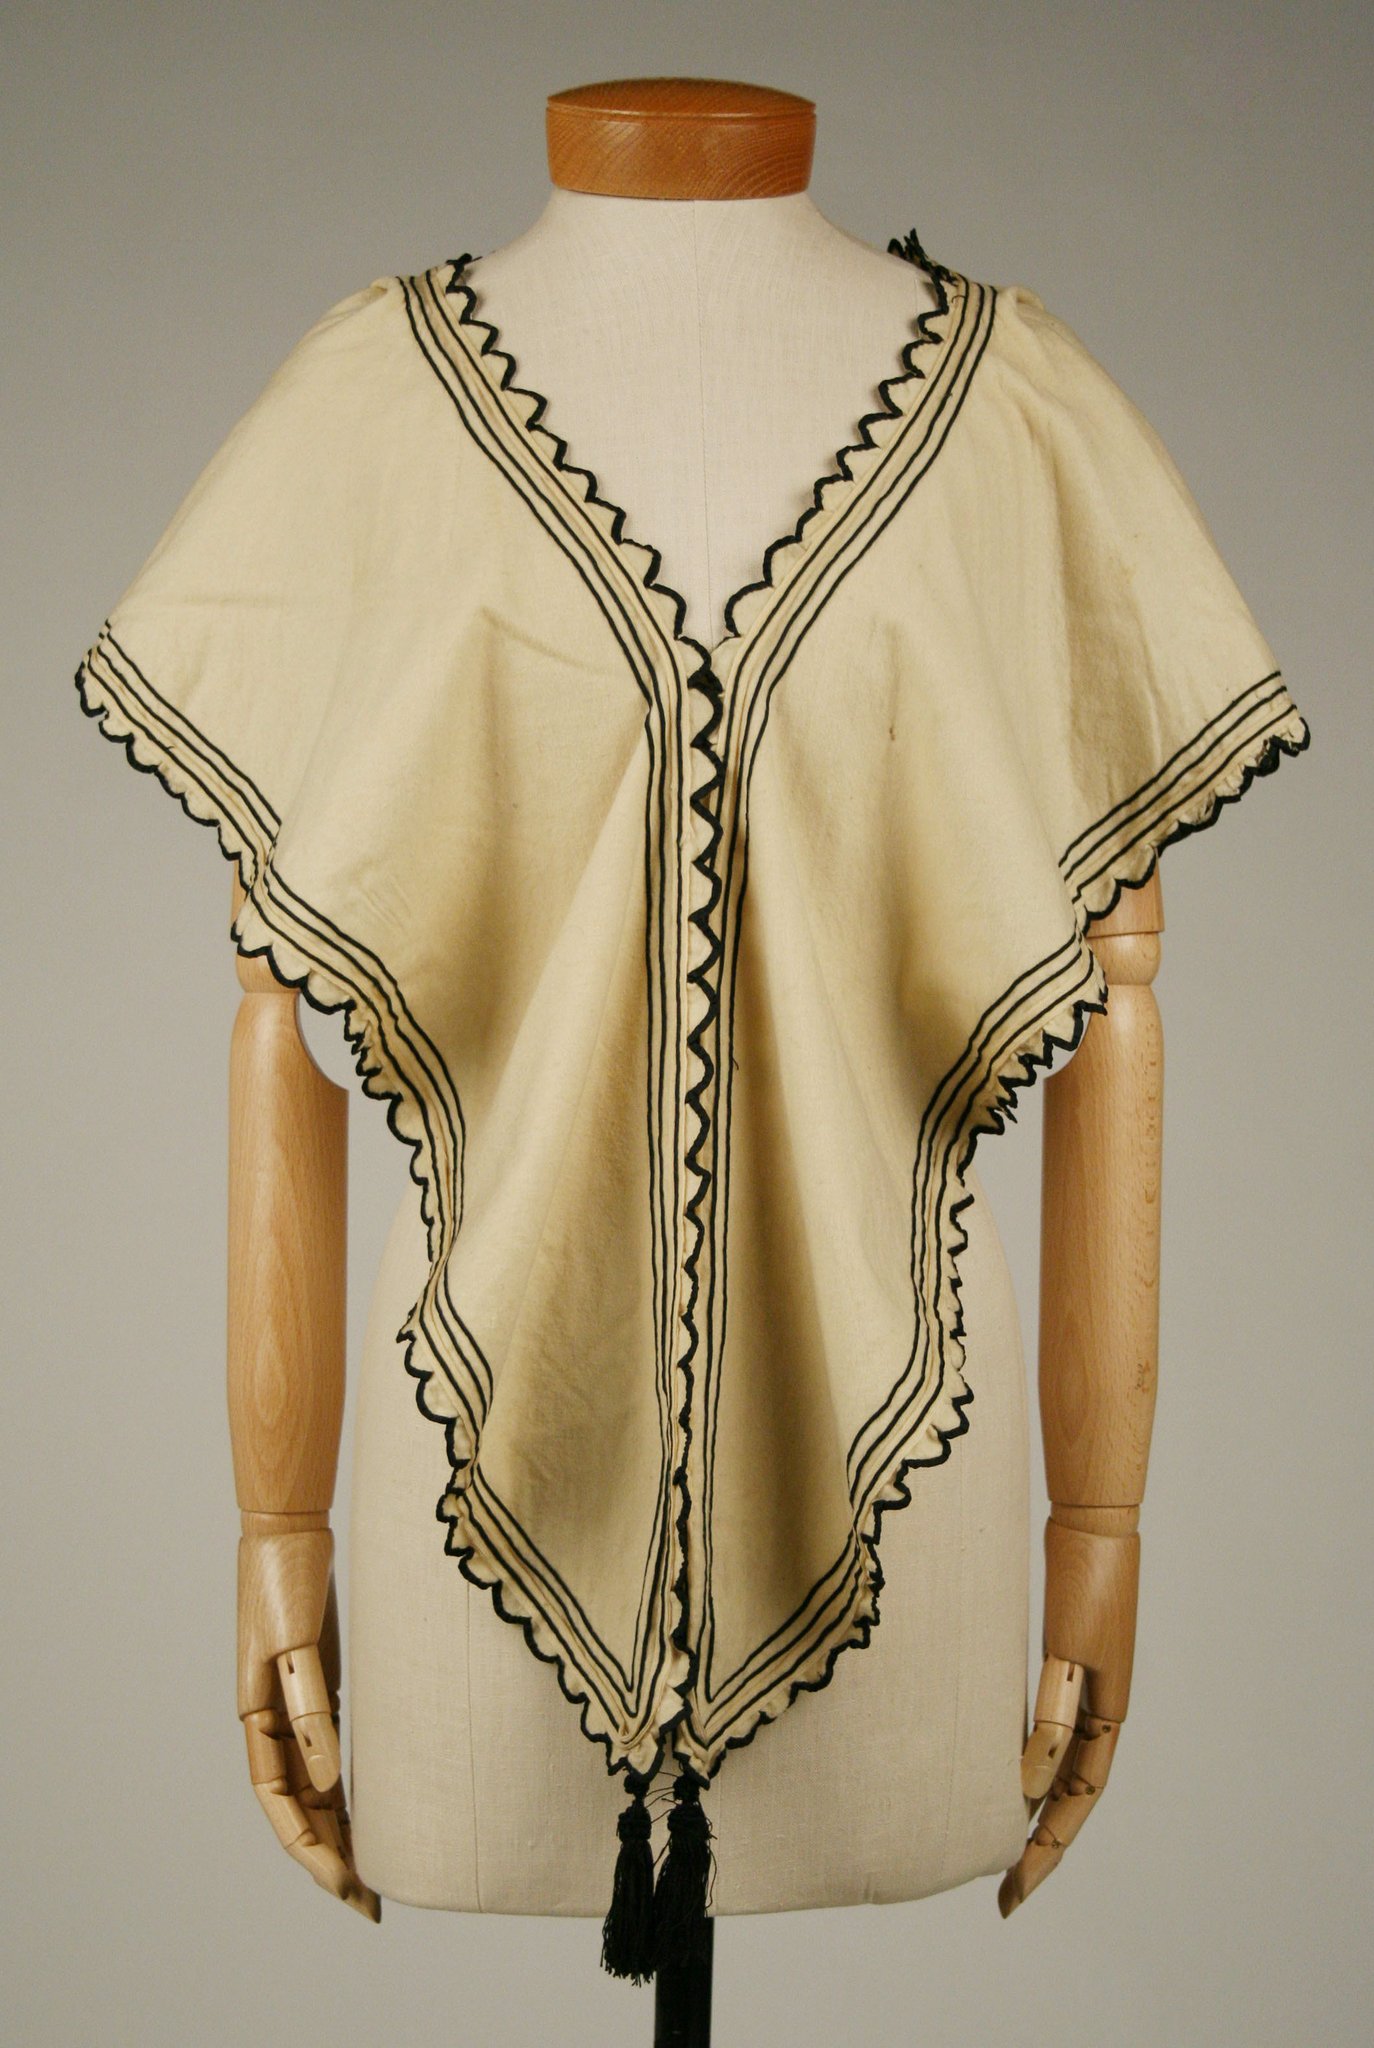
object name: hood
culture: british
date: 1865-1870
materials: cotton, silk, wool